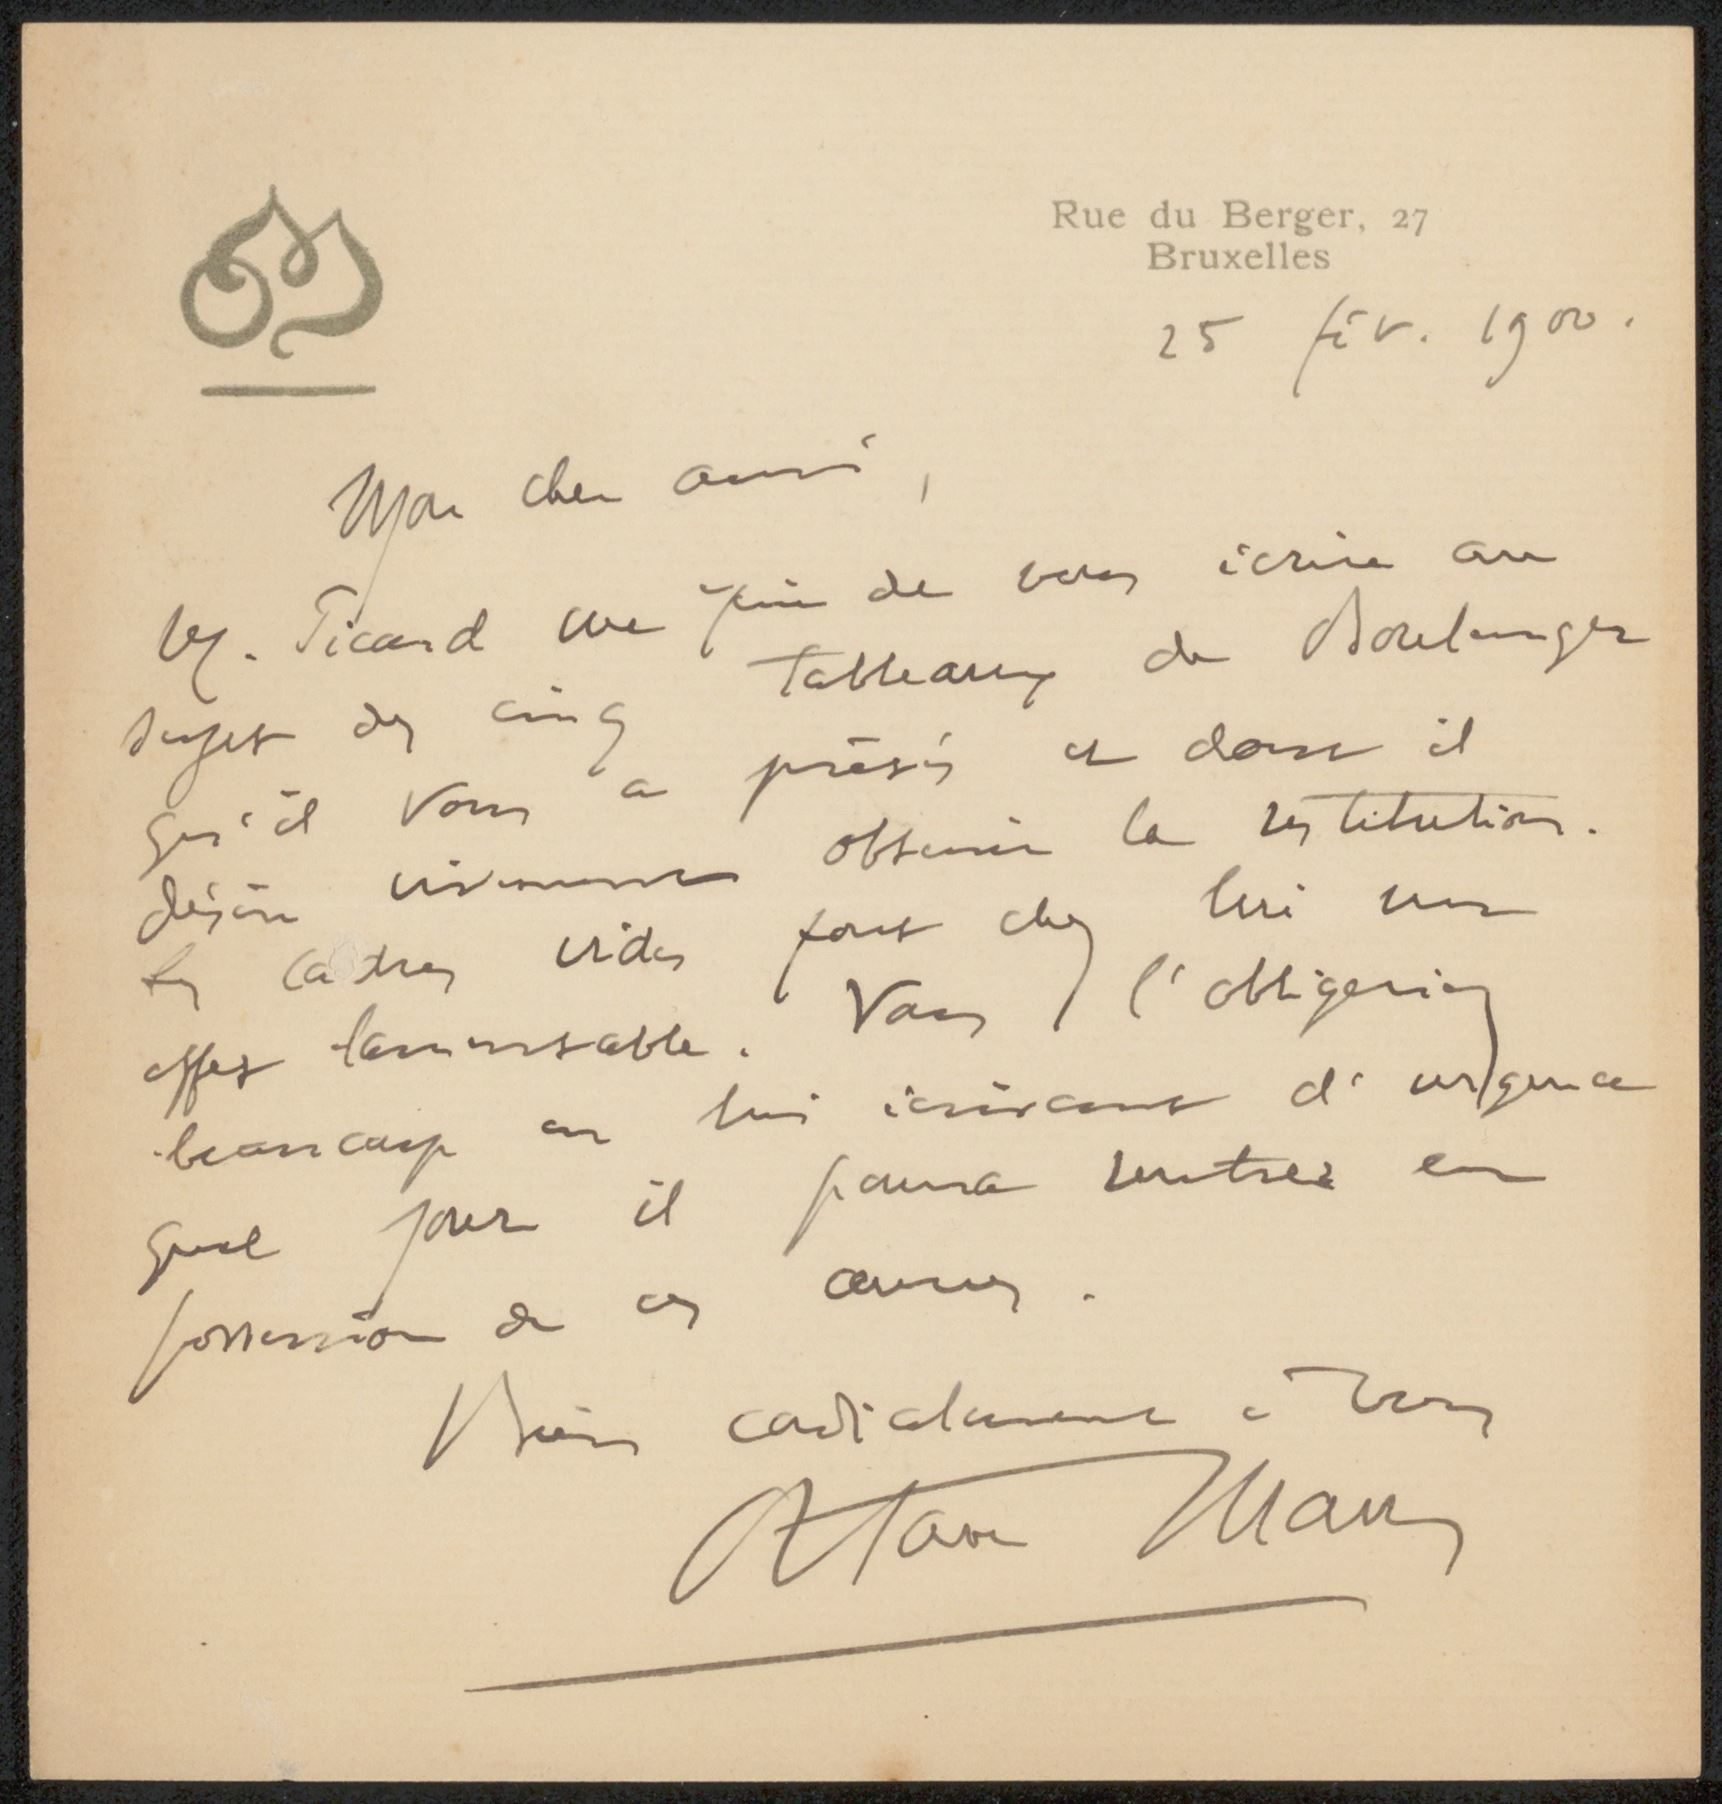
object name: letter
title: Brief aan Philip Zilcken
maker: octave maus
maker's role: painter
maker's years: 1856-1919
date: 1900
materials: ink, paper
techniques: pen, printing, writing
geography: brussels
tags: edmond picard, draughtsman, philip zilcken, painting (including book-illumination, miniature-painting)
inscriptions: watermark, collector's mark: ‘RPK’, monogram: ‘OM’